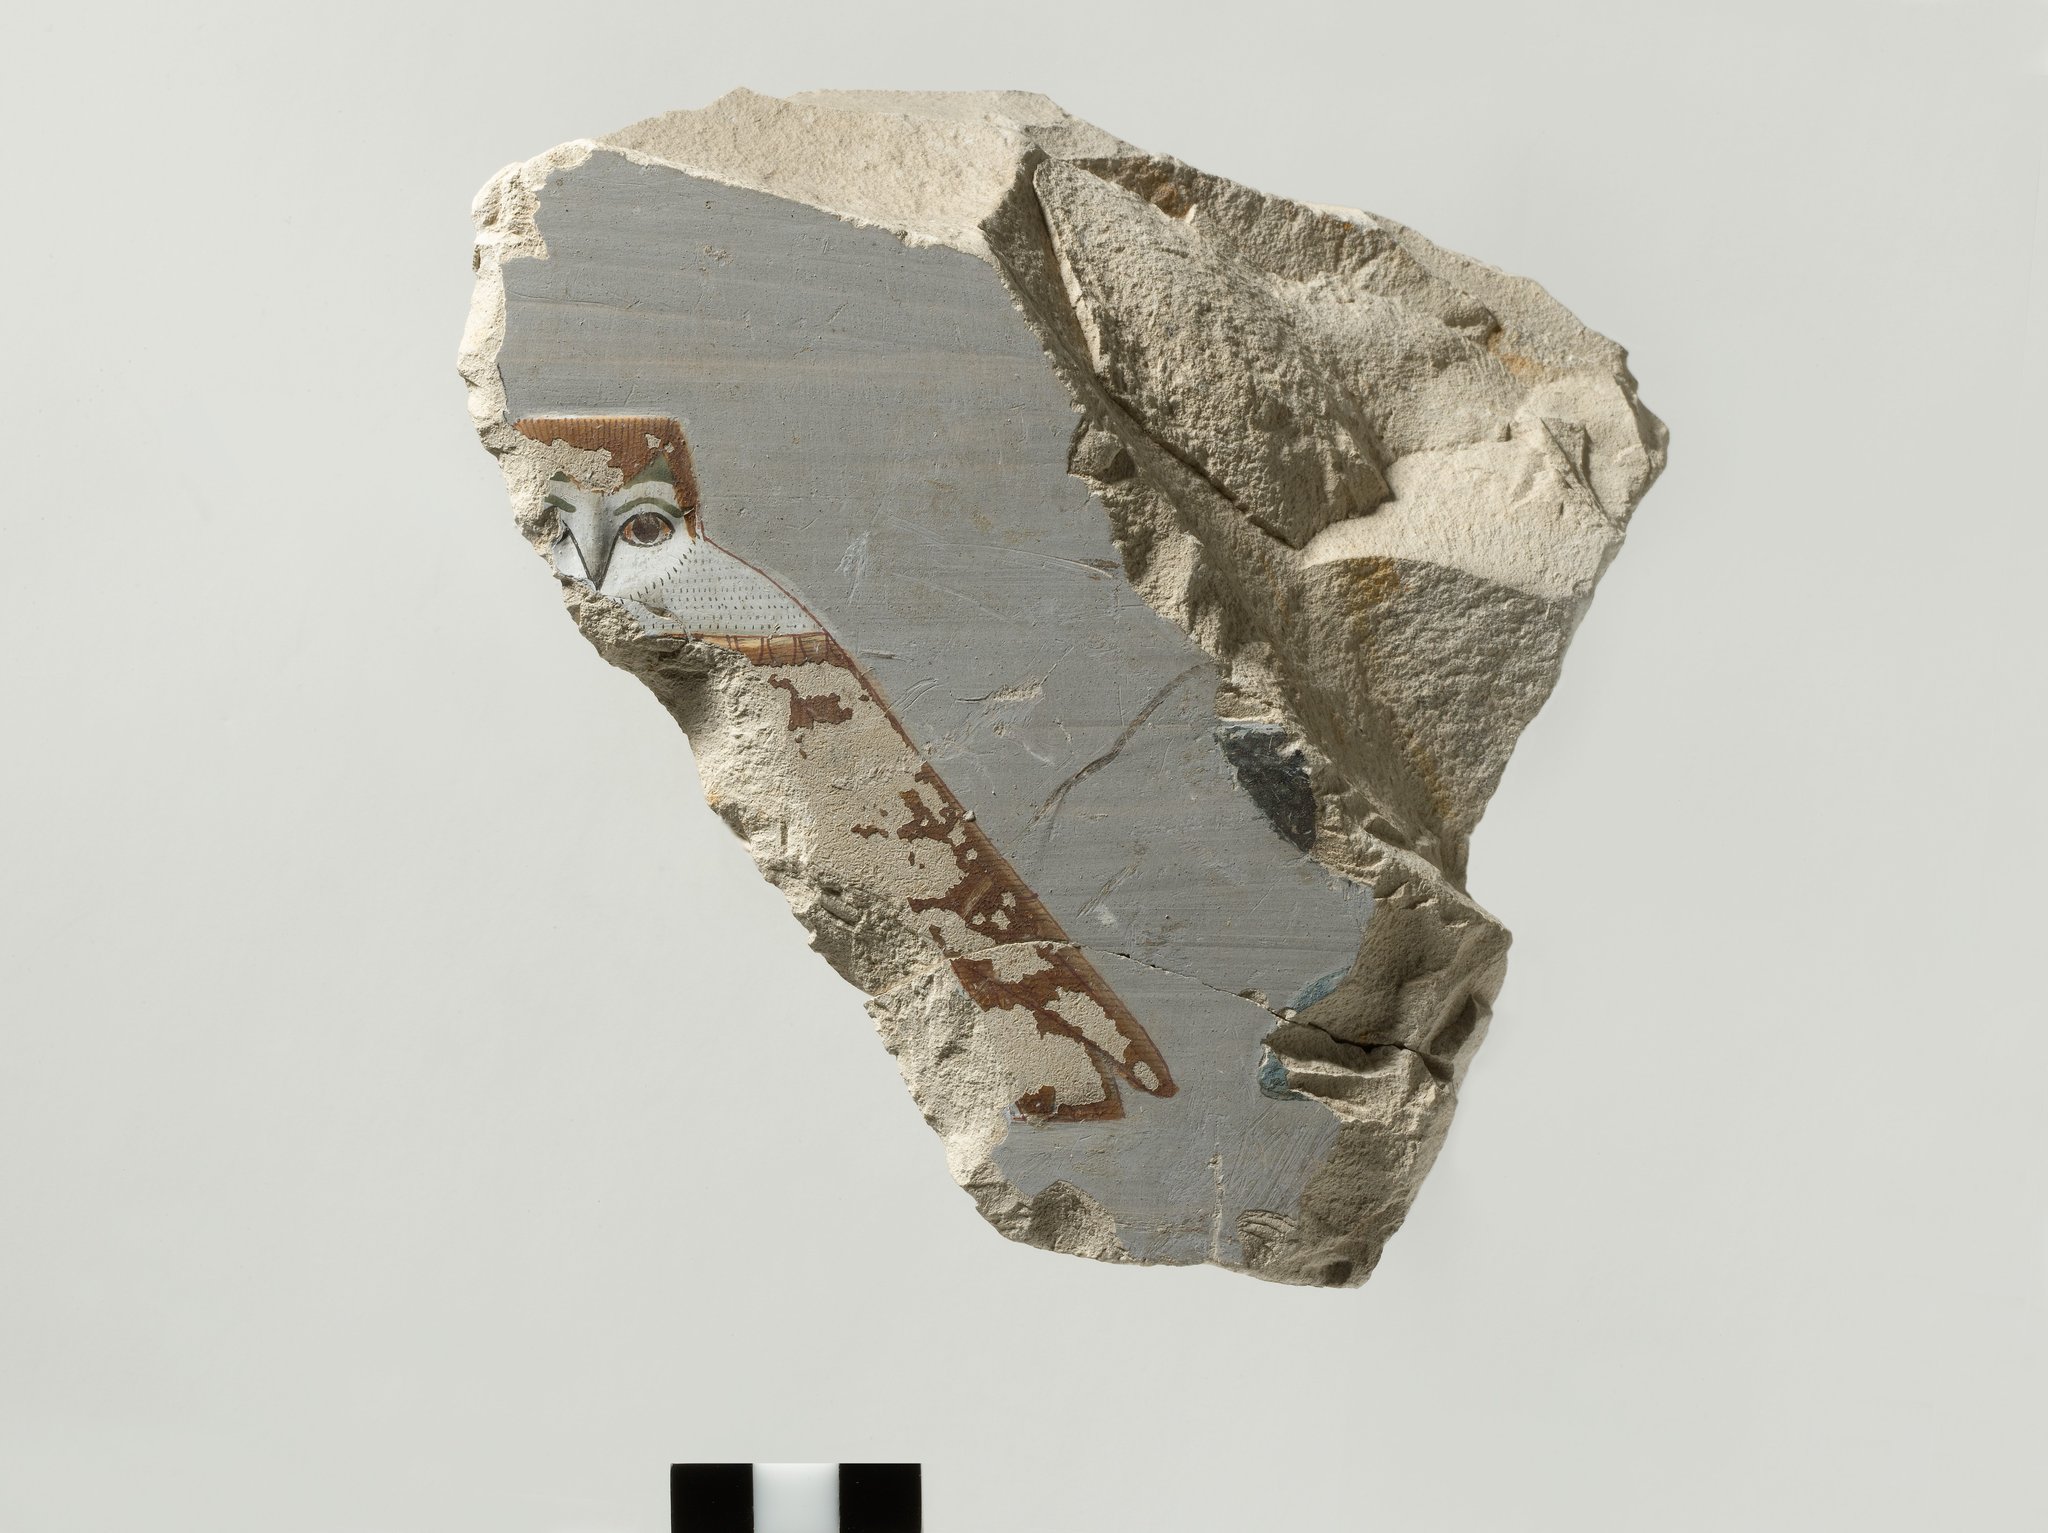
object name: relief fragment, tomb of meketre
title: Relief fragments from tomb of Meketre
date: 1981-1975 BCE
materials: limestone, paint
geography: egypt